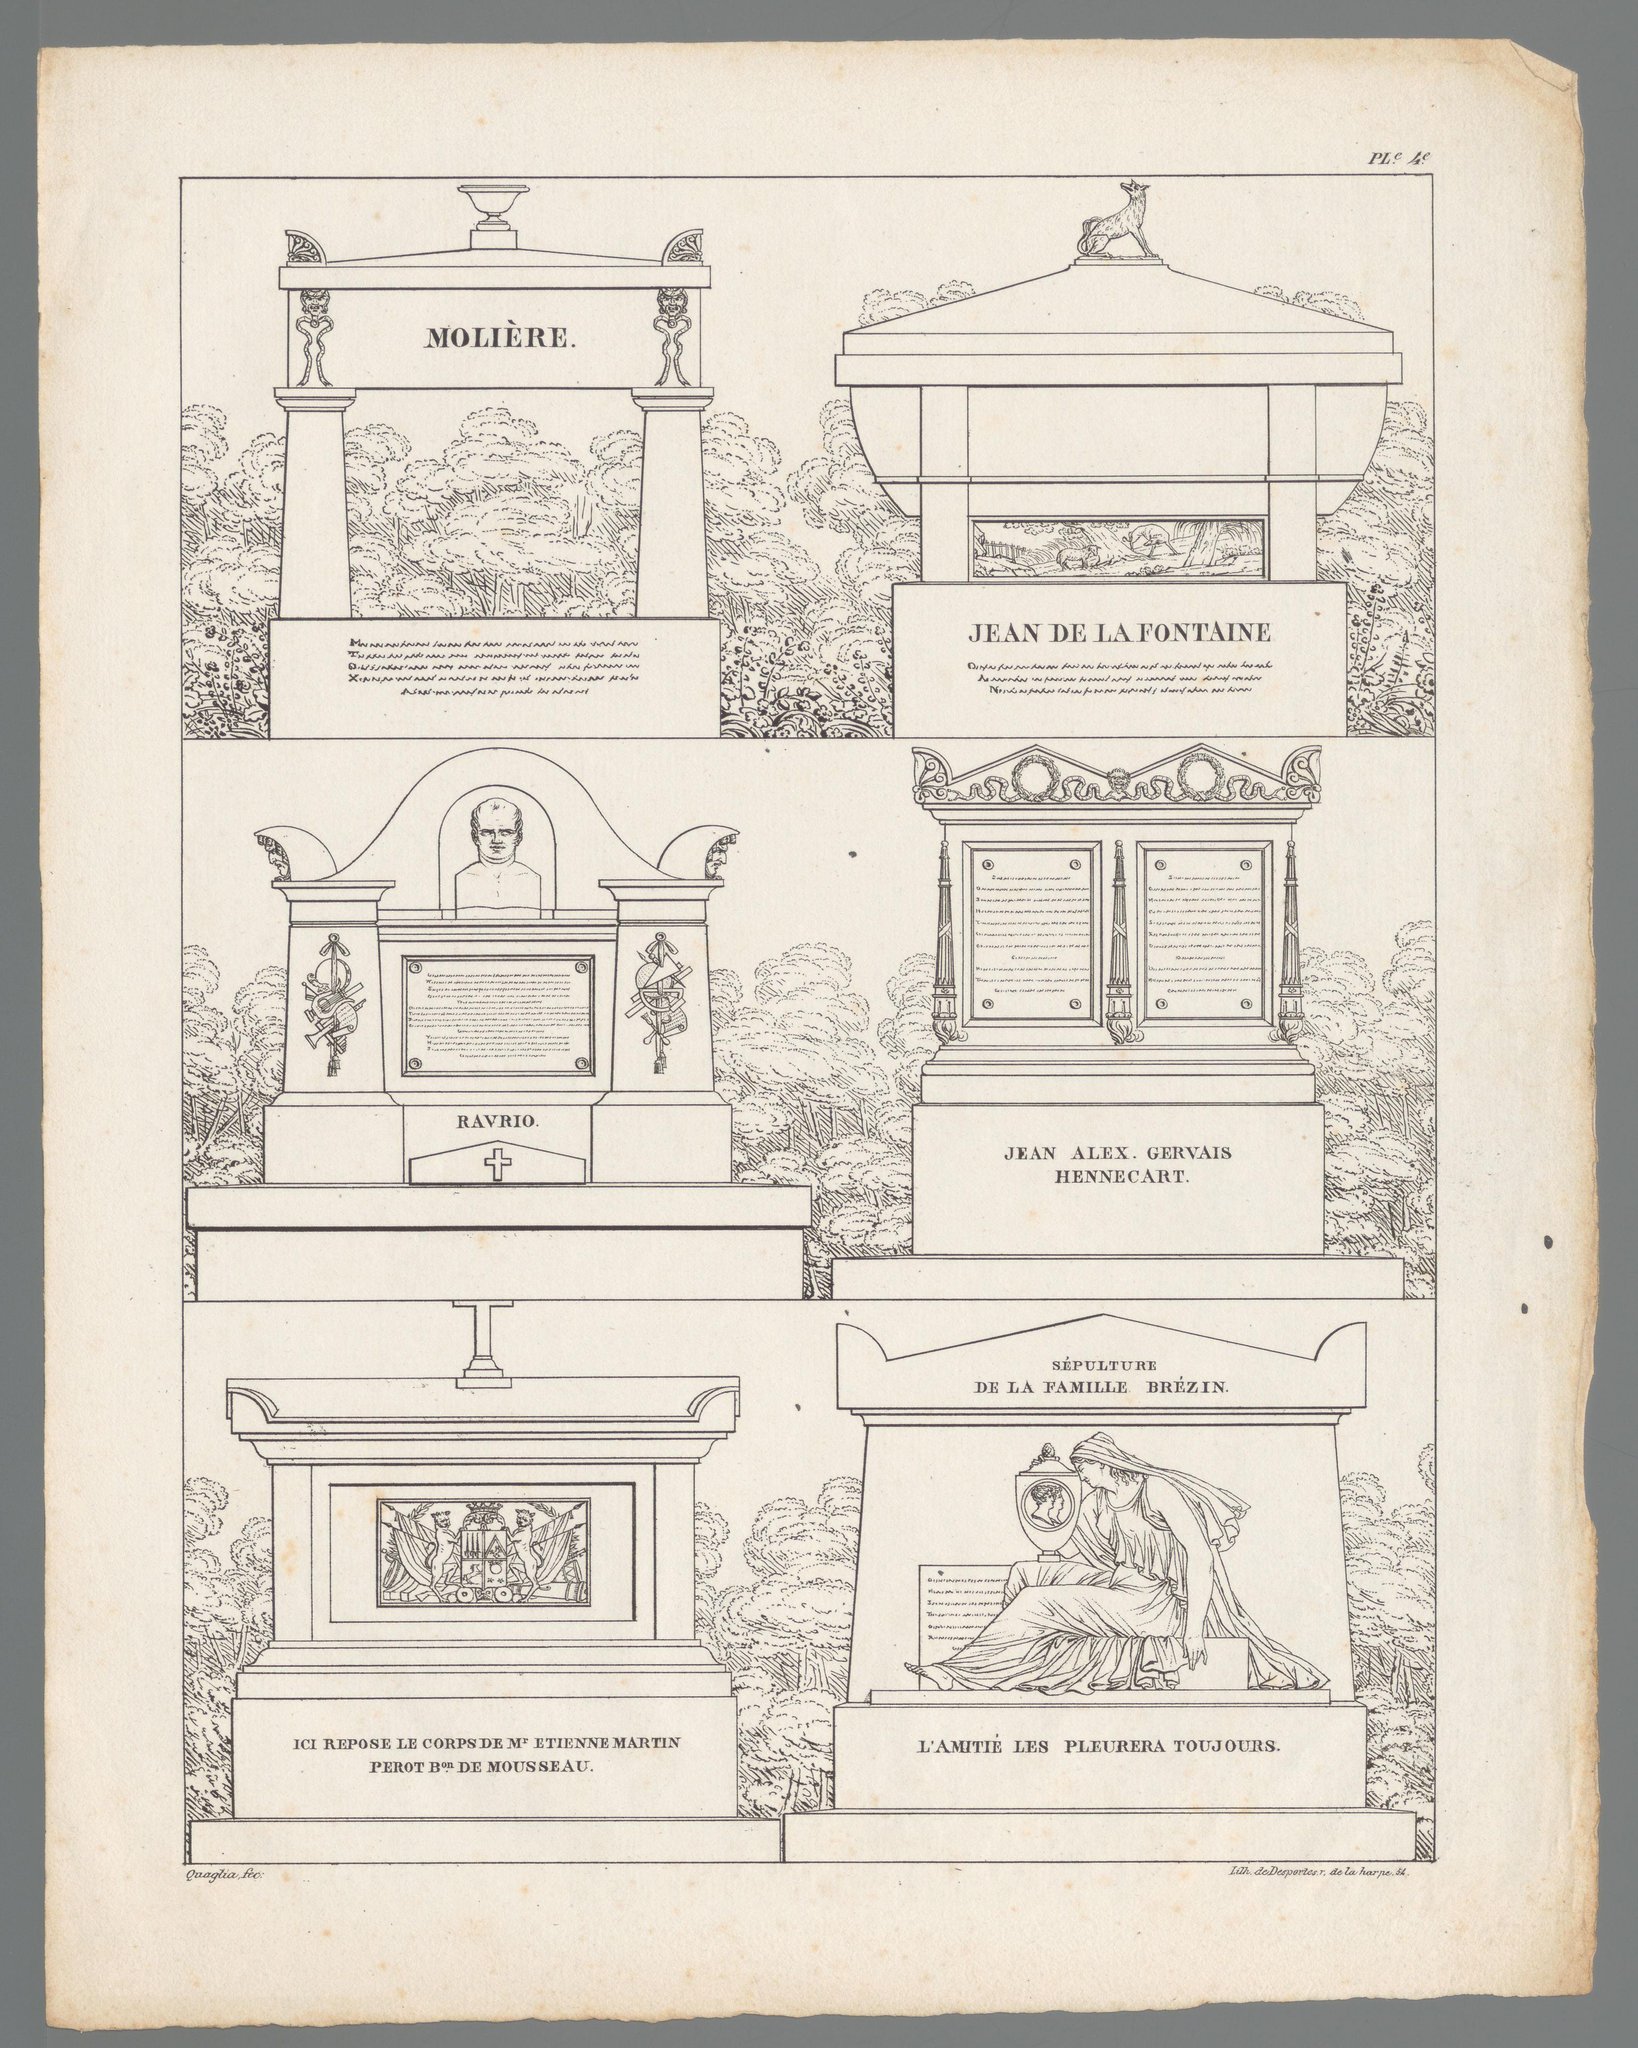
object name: print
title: Zes grafmonumenten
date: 1803-1869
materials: paper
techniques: lithograph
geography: paris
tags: cemetery, park-like burying ground